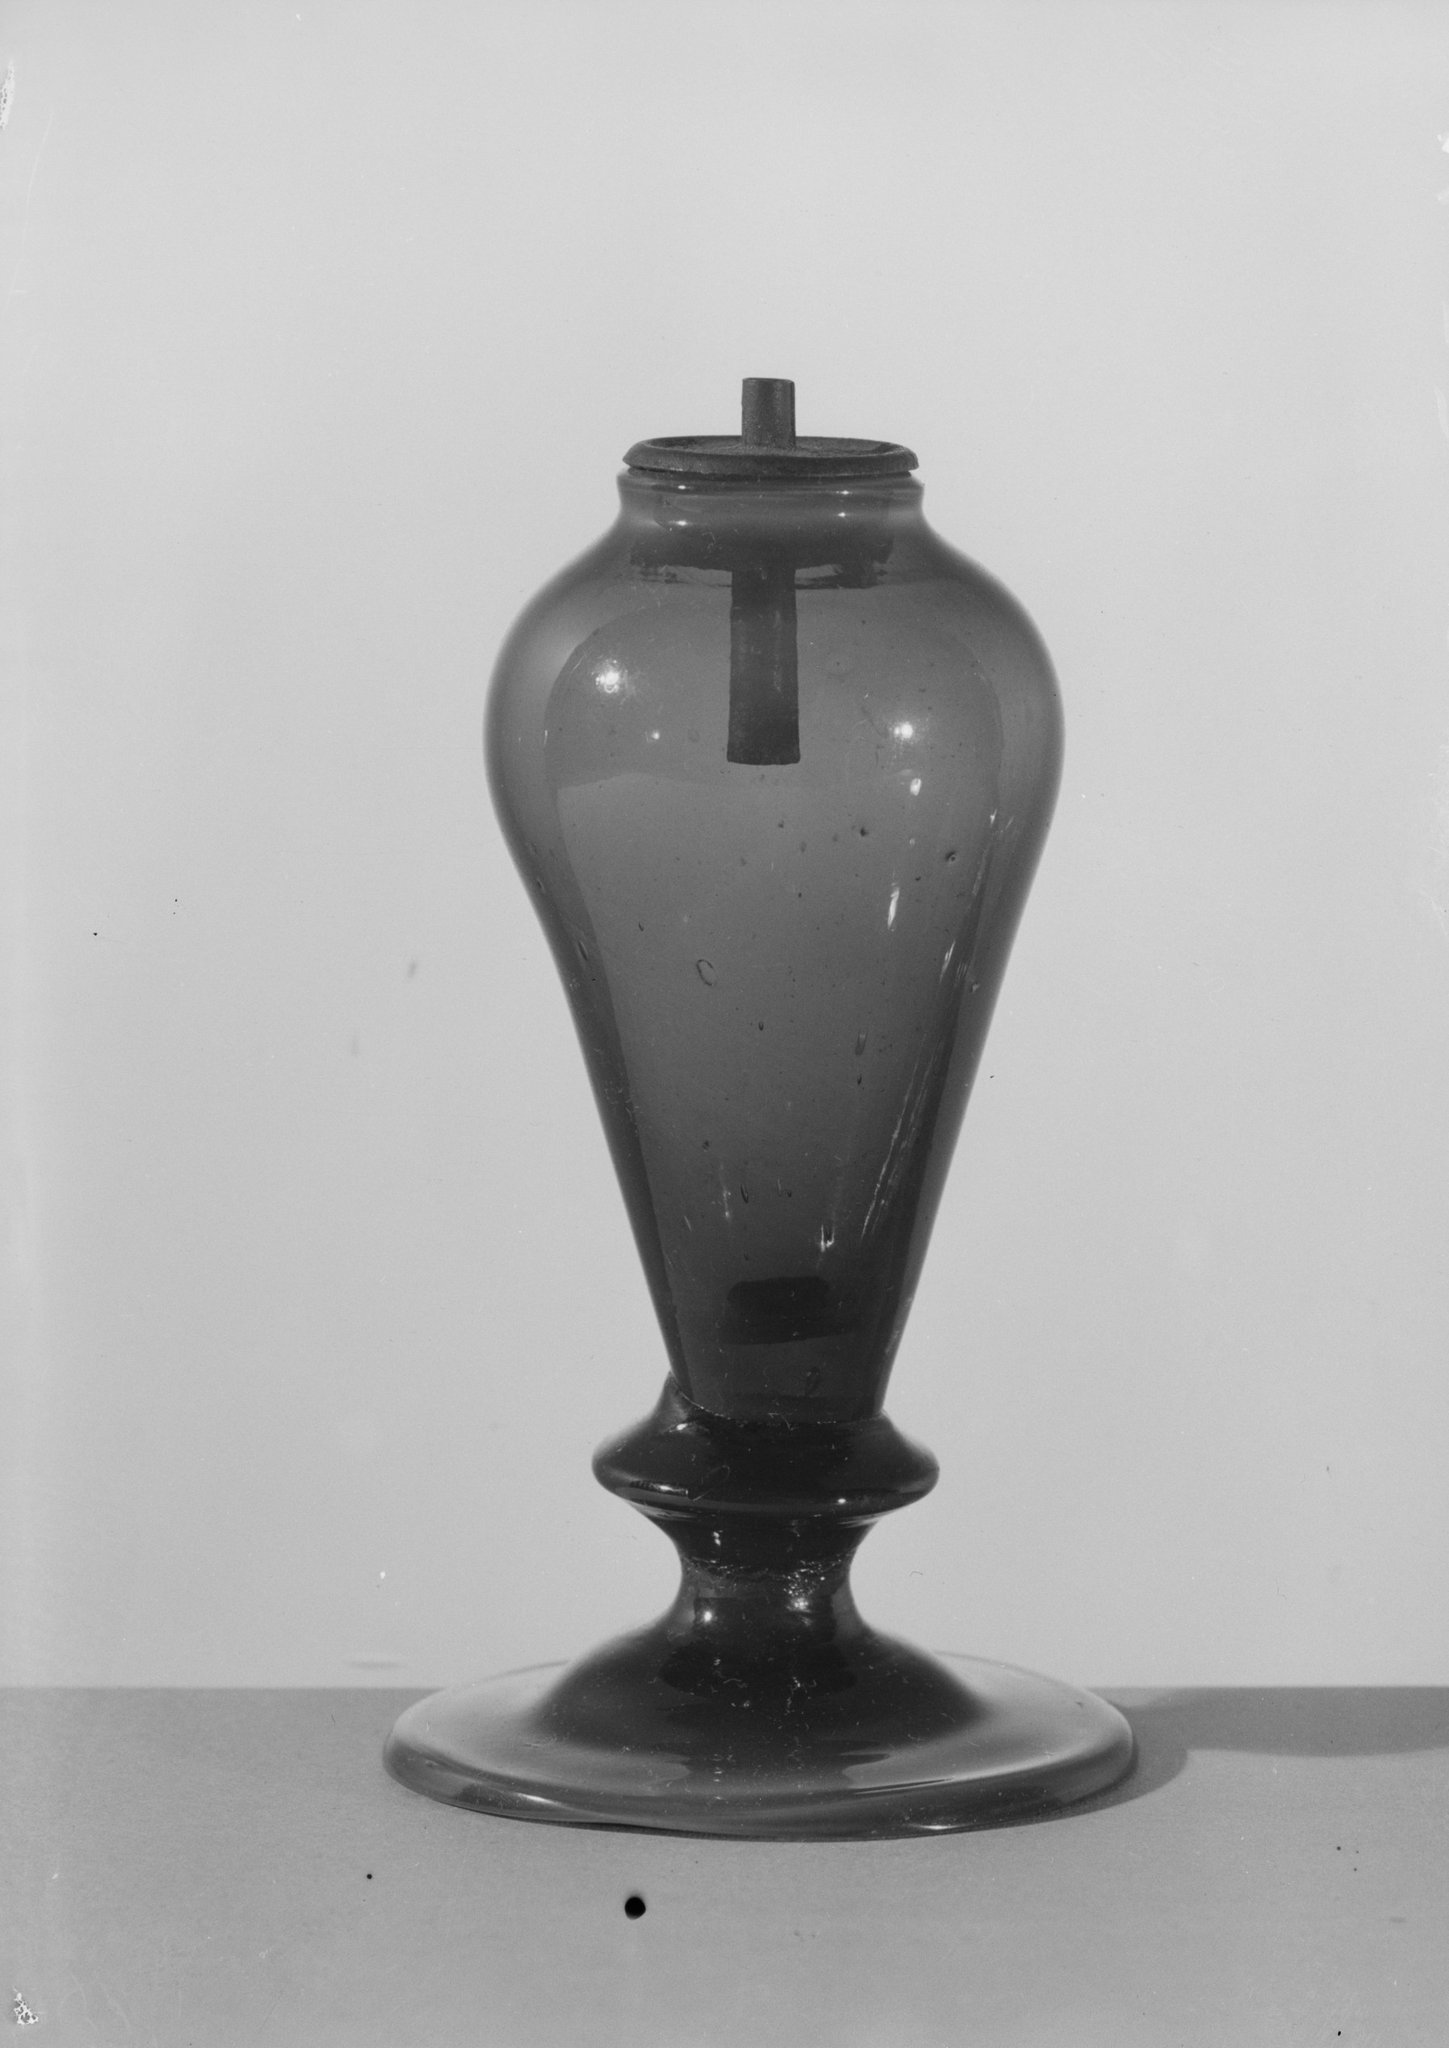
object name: lamp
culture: american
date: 1801-1900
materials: glass, tin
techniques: glassblowing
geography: united states